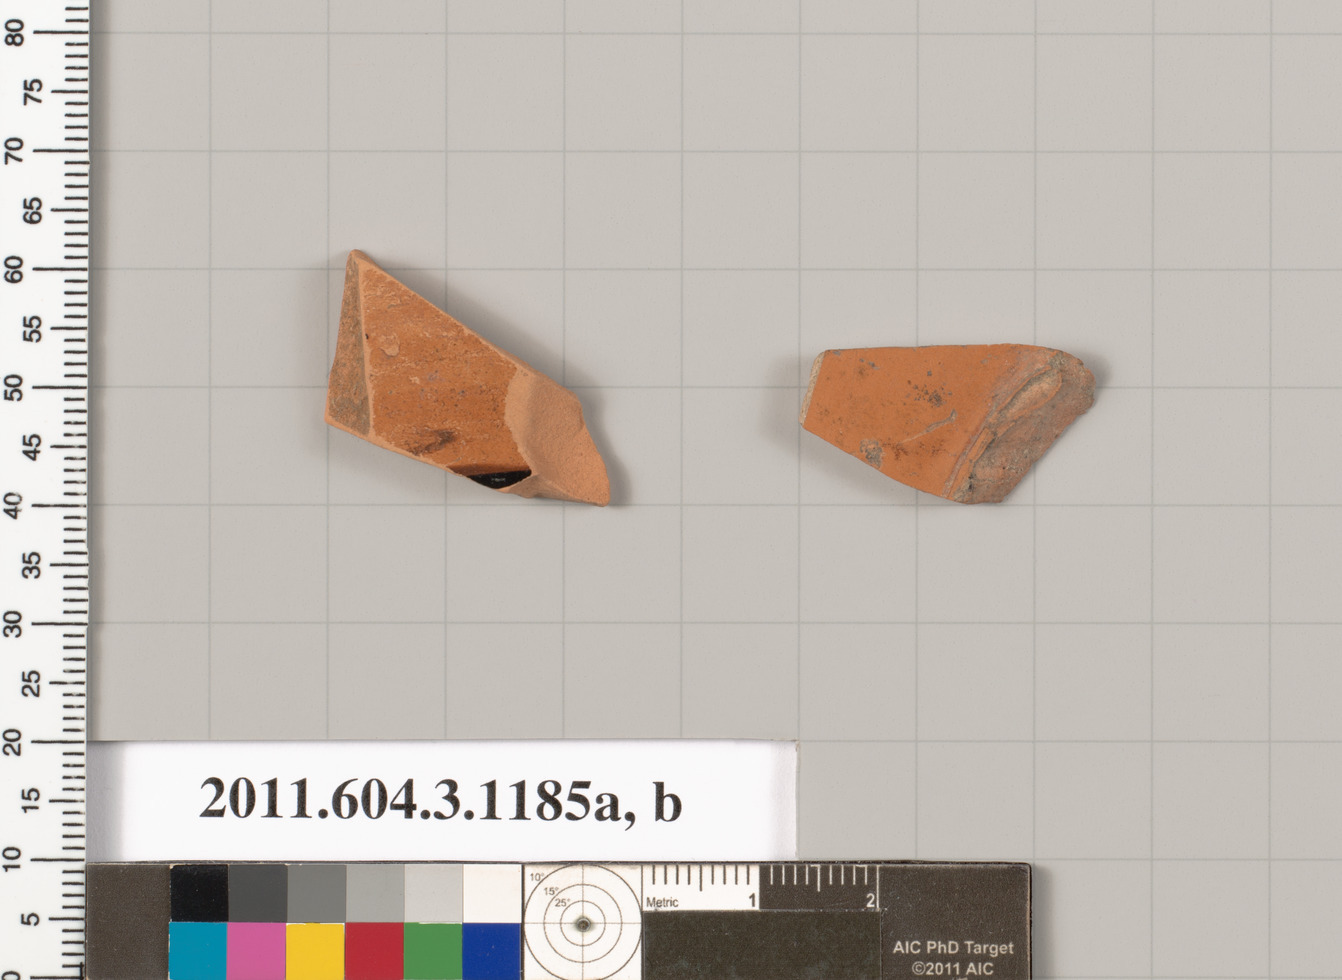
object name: mastoid or kyathos fragment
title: Terracotta fragments of mastoids (drinking cups with narrow base) or kyathoi (cup-shaped ladles)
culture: greek, attic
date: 534-468 BCE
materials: terracotta